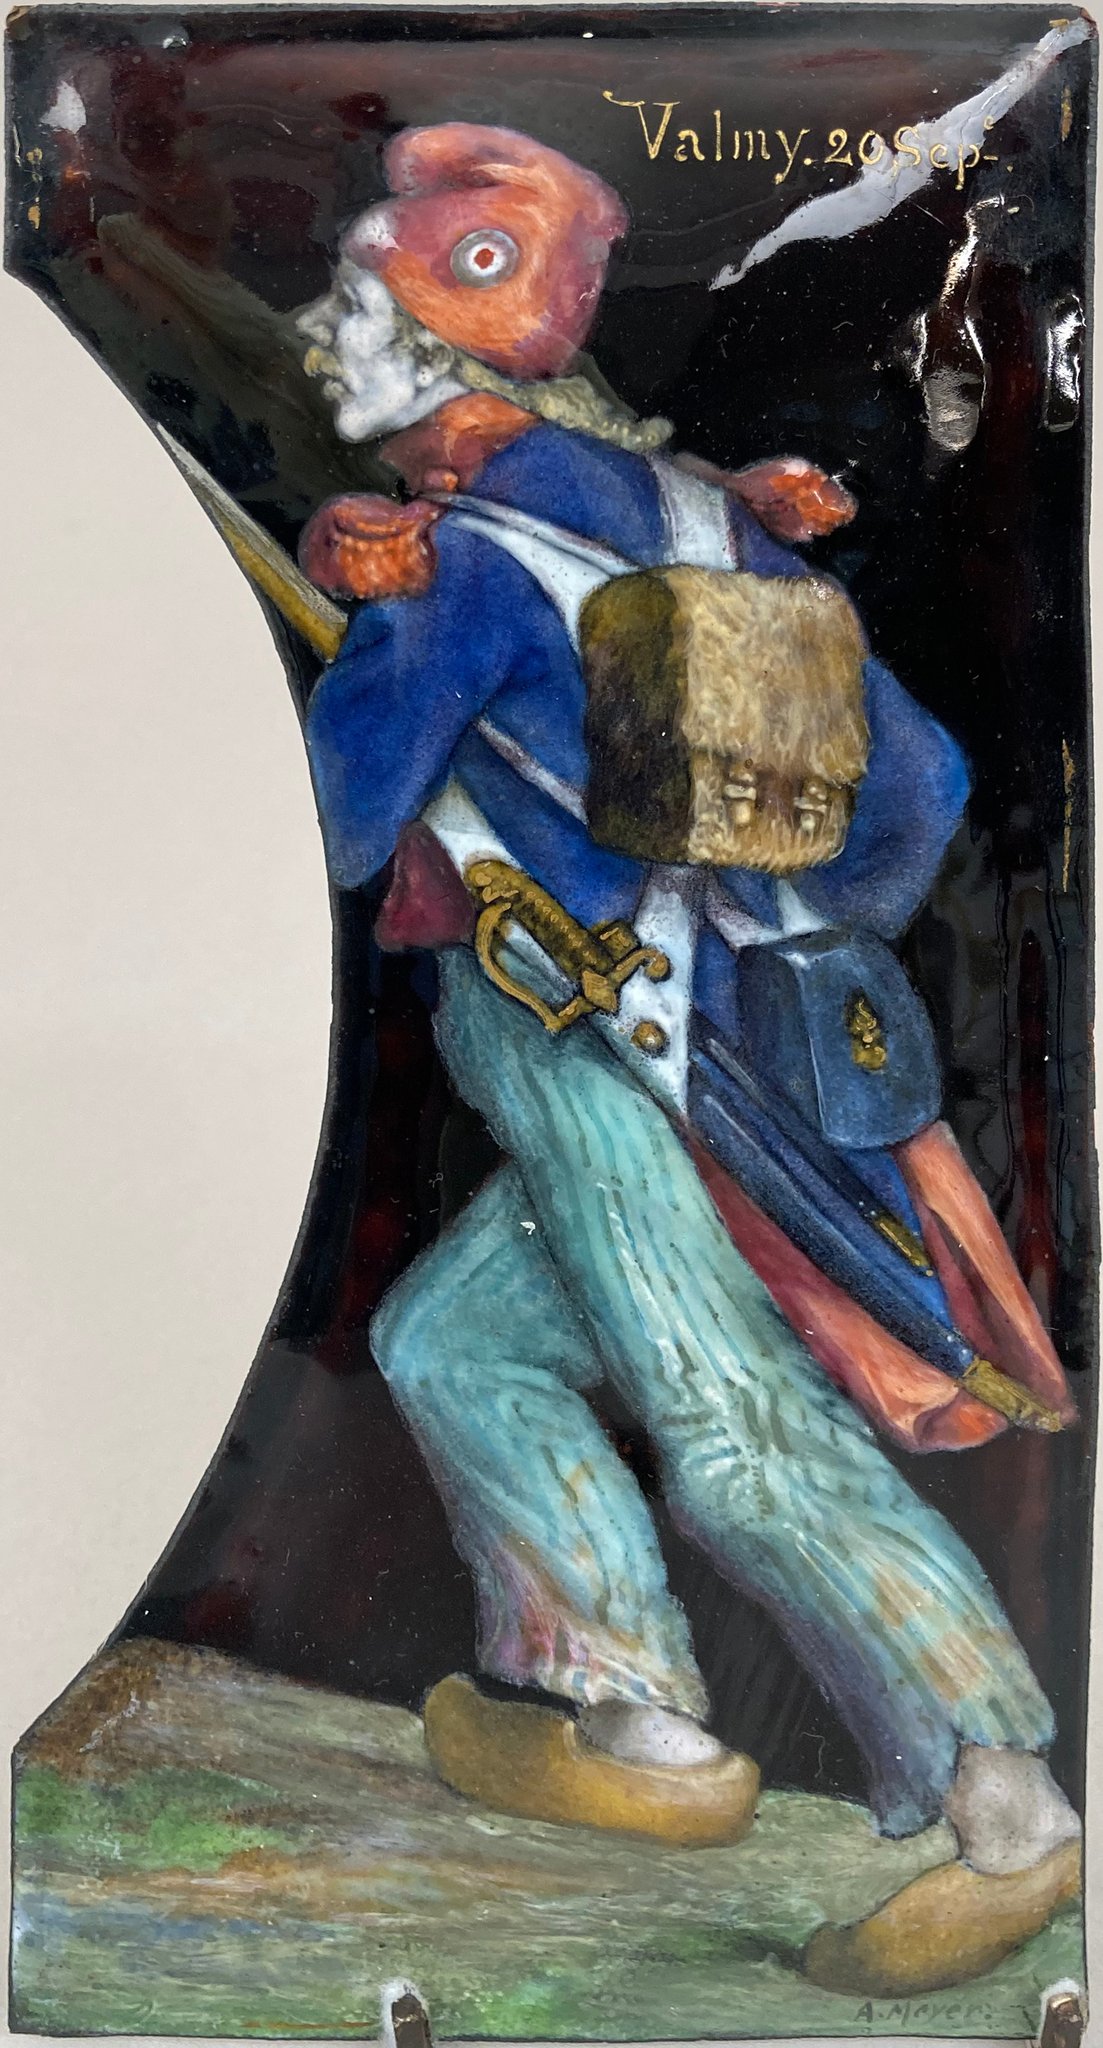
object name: plaque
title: A French Soldier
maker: alfred-bernard meyer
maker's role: enameler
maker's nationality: french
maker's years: 1832-1904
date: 1892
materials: copper, enamel, gilt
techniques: painting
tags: soldiers,men